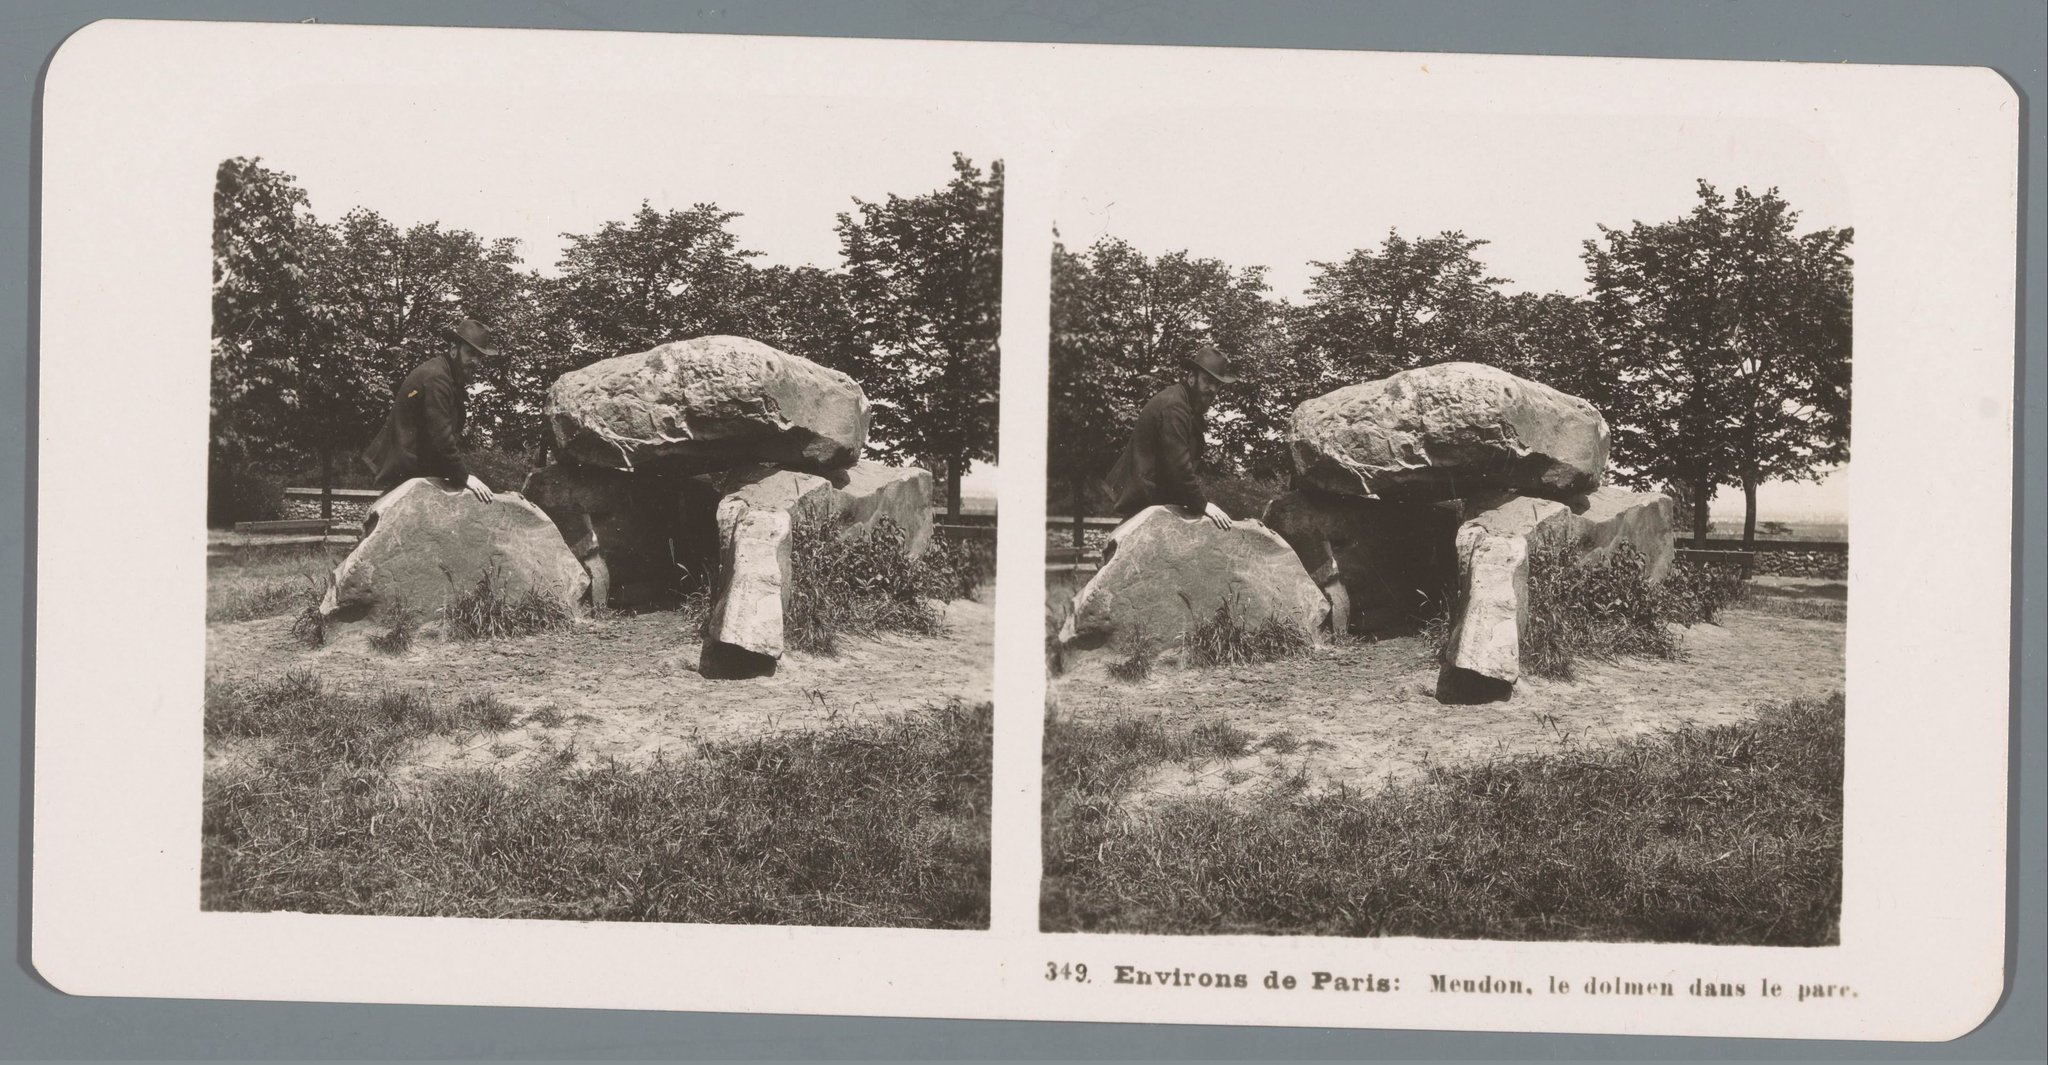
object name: stereograph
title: Hunebed te Meudon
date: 1906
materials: cardboard, photographic support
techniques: gelatin silver print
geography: meudon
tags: megalithic chambered tomb, dolmen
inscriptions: number: ‘349’, inscription: ‘Neue Photographische Gesellschaft A.-G. Steglitz-Berlin 1906.’